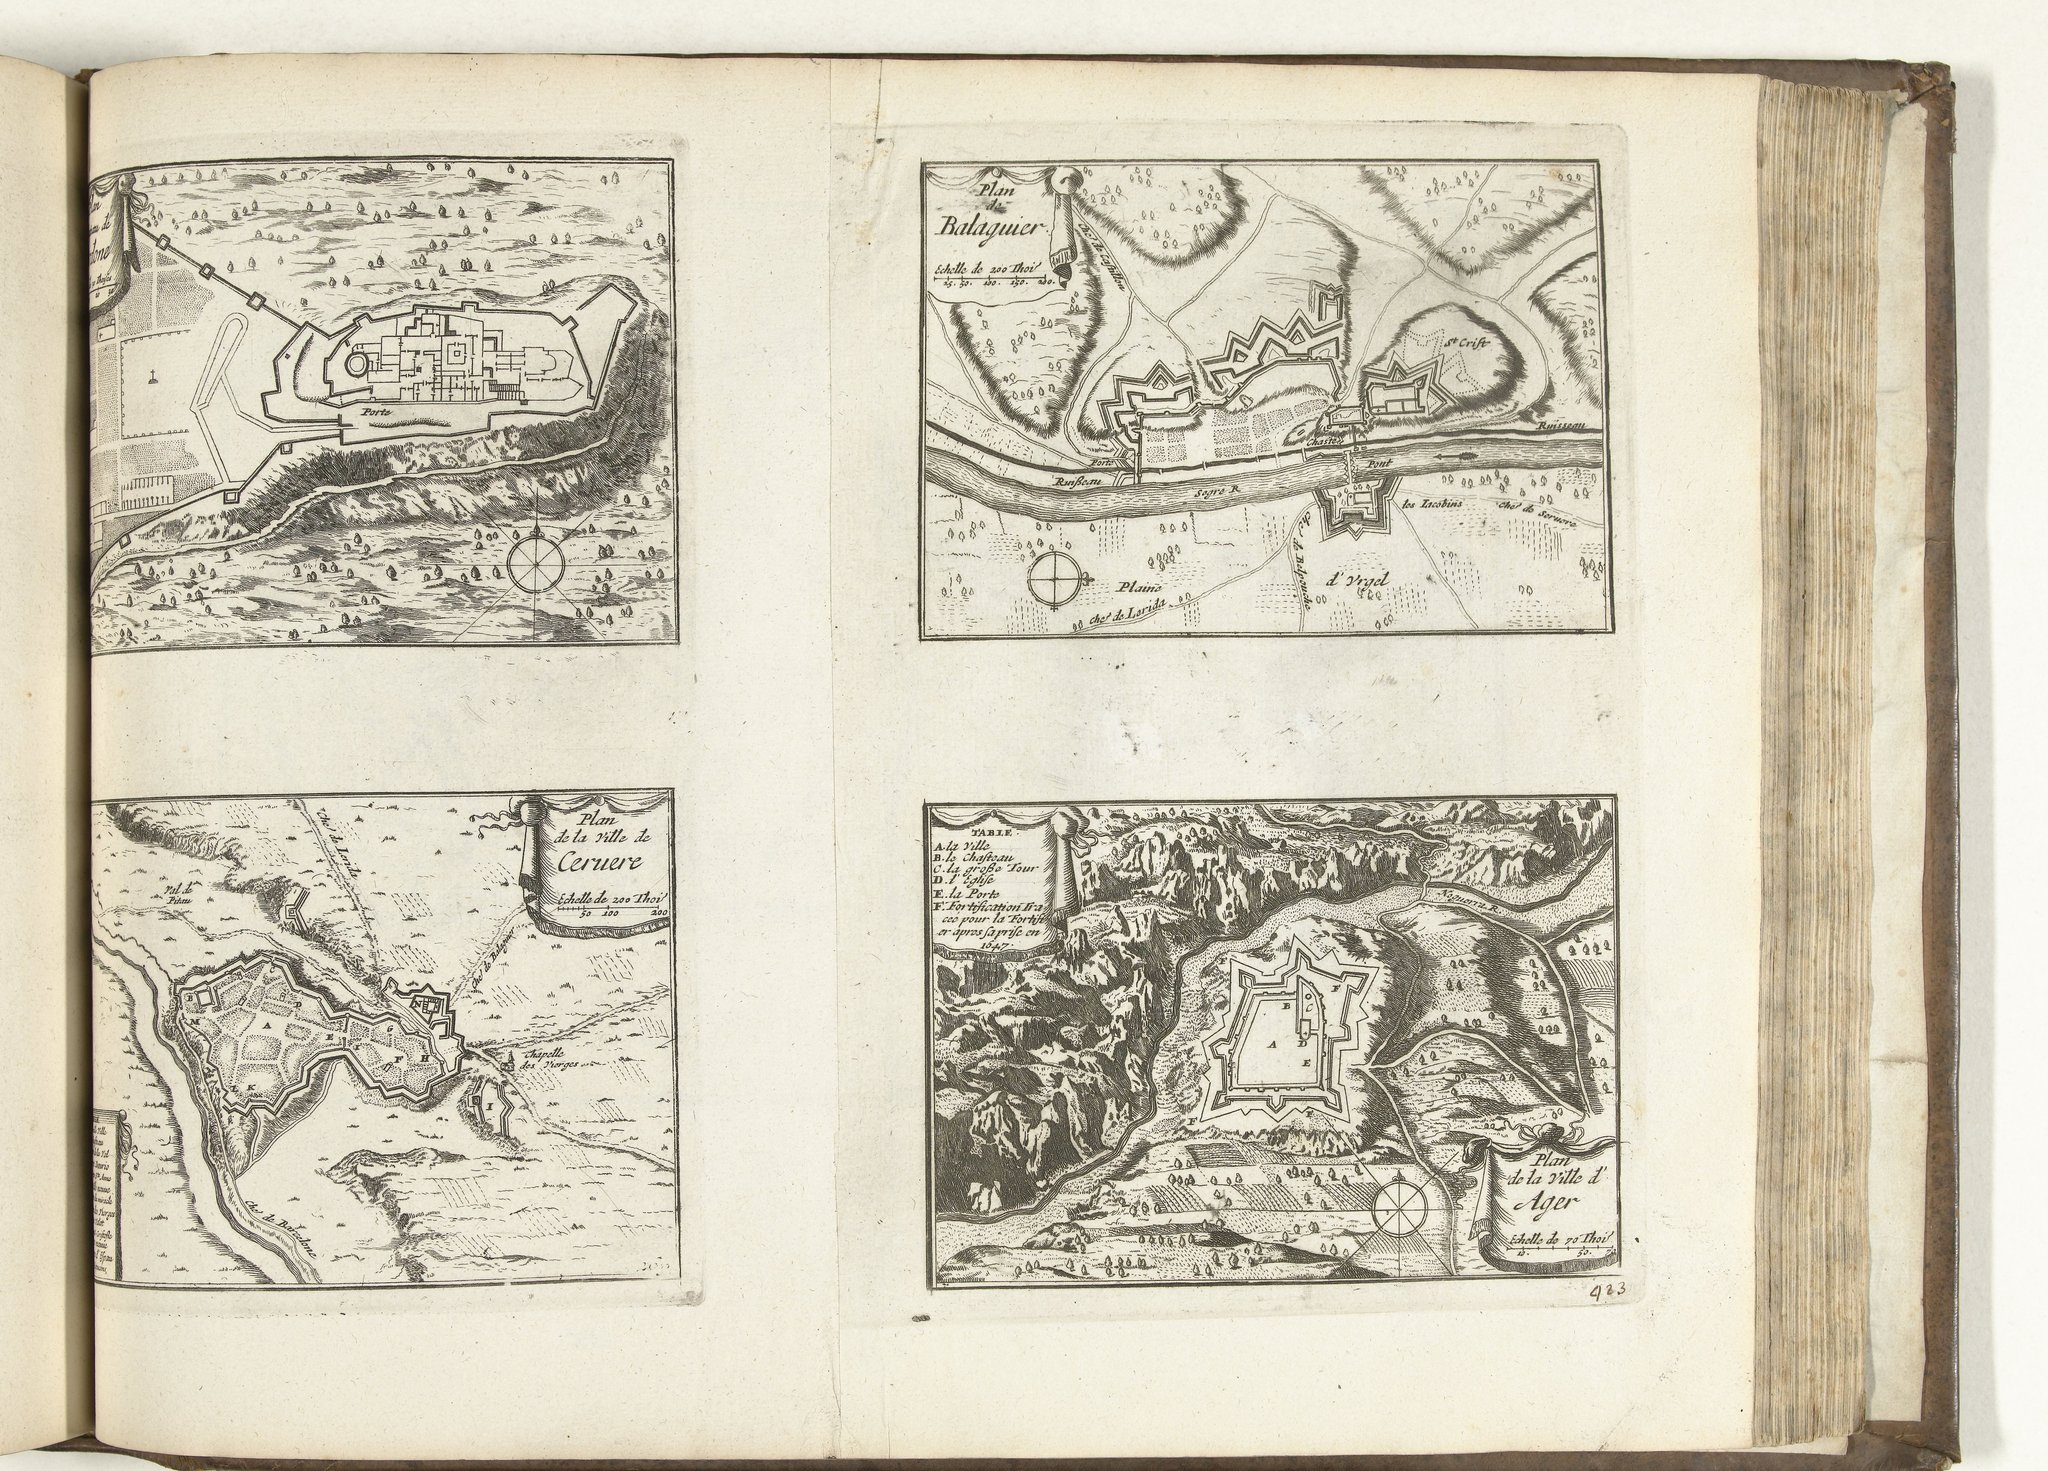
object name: print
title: Les Forces de l'Europe, Asie, Afrique et Amerique (...) Comme aussi les Cartes des Côtes de France et d'Espagne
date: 1726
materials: paper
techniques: etching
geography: northern netherlands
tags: fortress, maps of cities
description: Blad met vier plattegronden van de versterkingen om Cardona en andere plaatsen in Catalonië. Plaat nr. 423 in deel XVII van het prentwerk: Les Forces de l'Europe, Asie, Afrique et Amerique ... Comme aussi les Cartes des Côtes de France et d'Espagne uit 1726, dit tweede deel met 271 met de hand genummerde platen van vermaarde sterke steden en vestingen in het kader van de Spaanse Successieoorlog 1701-1713. Voor het merendeel zijn deze platen gekopieerd naar de anonieme Franse platen van vermaarde sterke steden en vestingen: in Les forces de l'Europe en in: Le theatre de la guerre, dans les Pays-Bas, beide oorspronkelijk uitgegeven door Nicolas de Fer te Parijs (1693-1697) in het kader van de Negenjarige Oorlog. Titels en opschriften in het Frans. Blad samengesteld uit twee rechterhelften van verschillende platen aan elkaar geplakt.